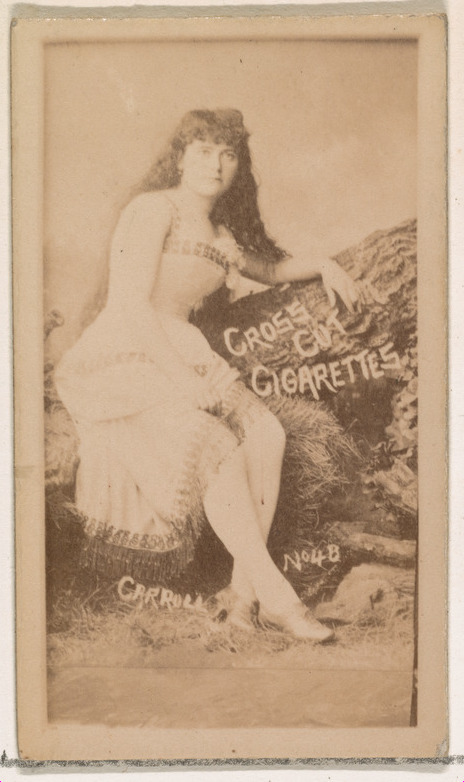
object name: print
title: Card Number 48, Carroll, from the Actors and Actresses series (N145-1) issued by Duke Sons & Co. to promote Cross Cut Cigarettes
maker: w. duke, sons & co.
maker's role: publisher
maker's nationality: american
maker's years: 1870-1920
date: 1880-1889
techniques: albumen silver print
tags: portraits,women,actresses